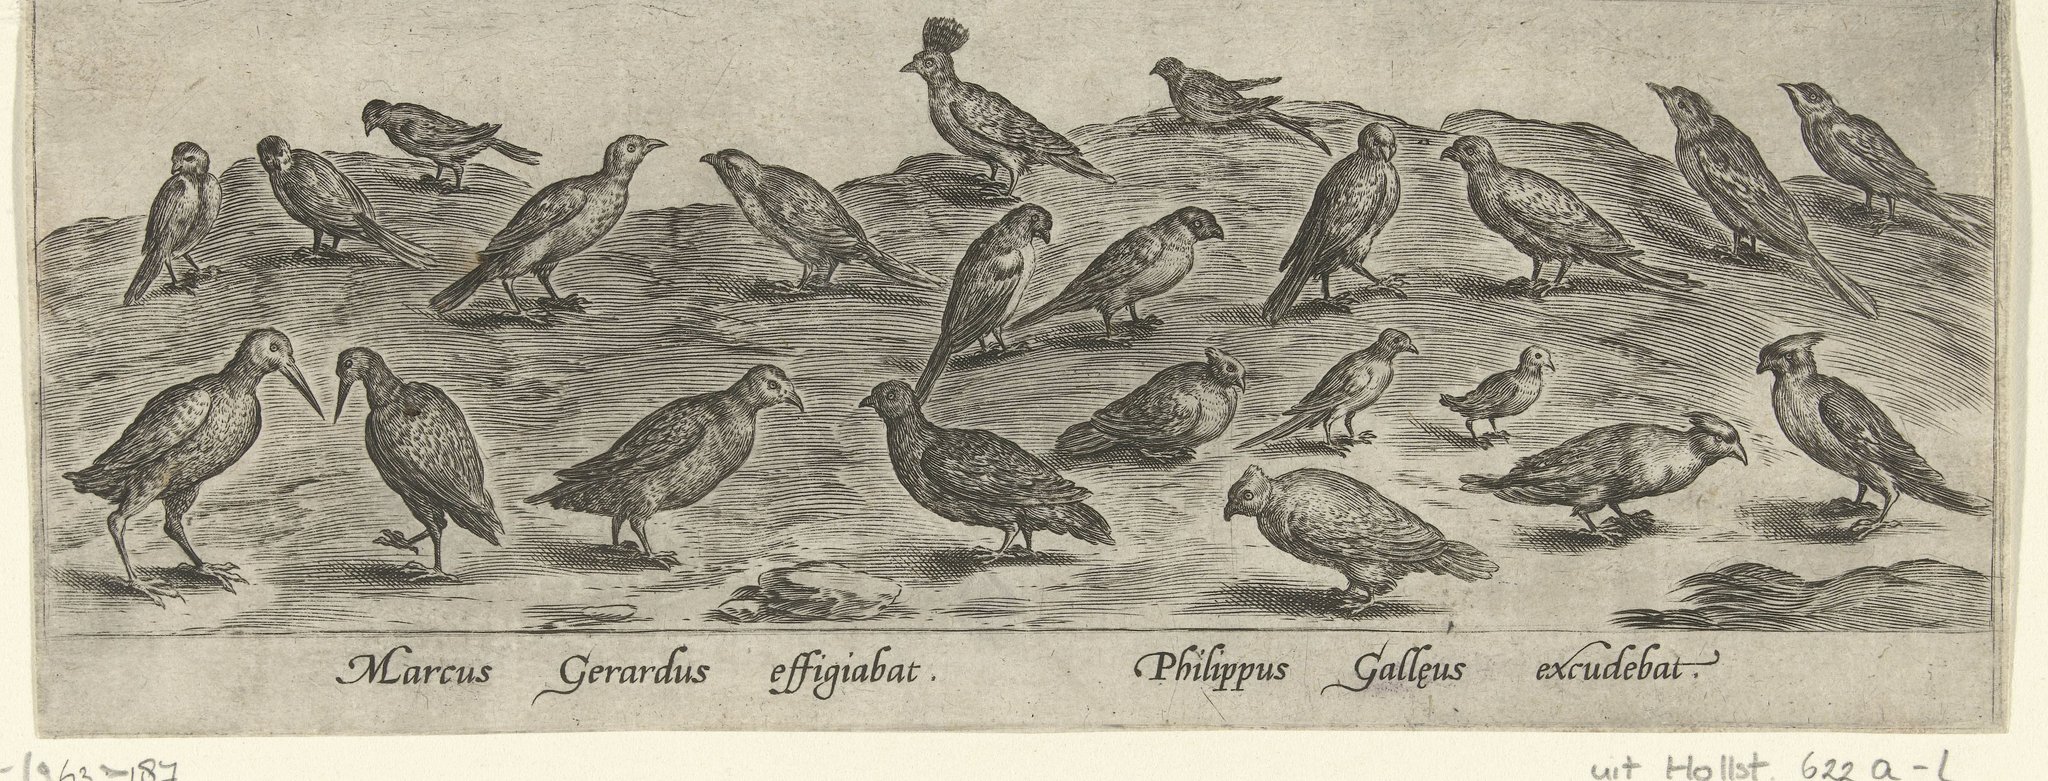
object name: print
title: Drieëntwintig vogels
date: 1547-1590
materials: paper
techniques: engraving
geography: antwerp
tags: birds, other birds: woodpecker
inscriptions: collector's mark: Lugt 2760, collector's mark: Lugt 2228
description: Drieëntwintig vogels, waaronder twee spechten (links). De prent maakt deel uit van een prentserie over vogels en vlinders.